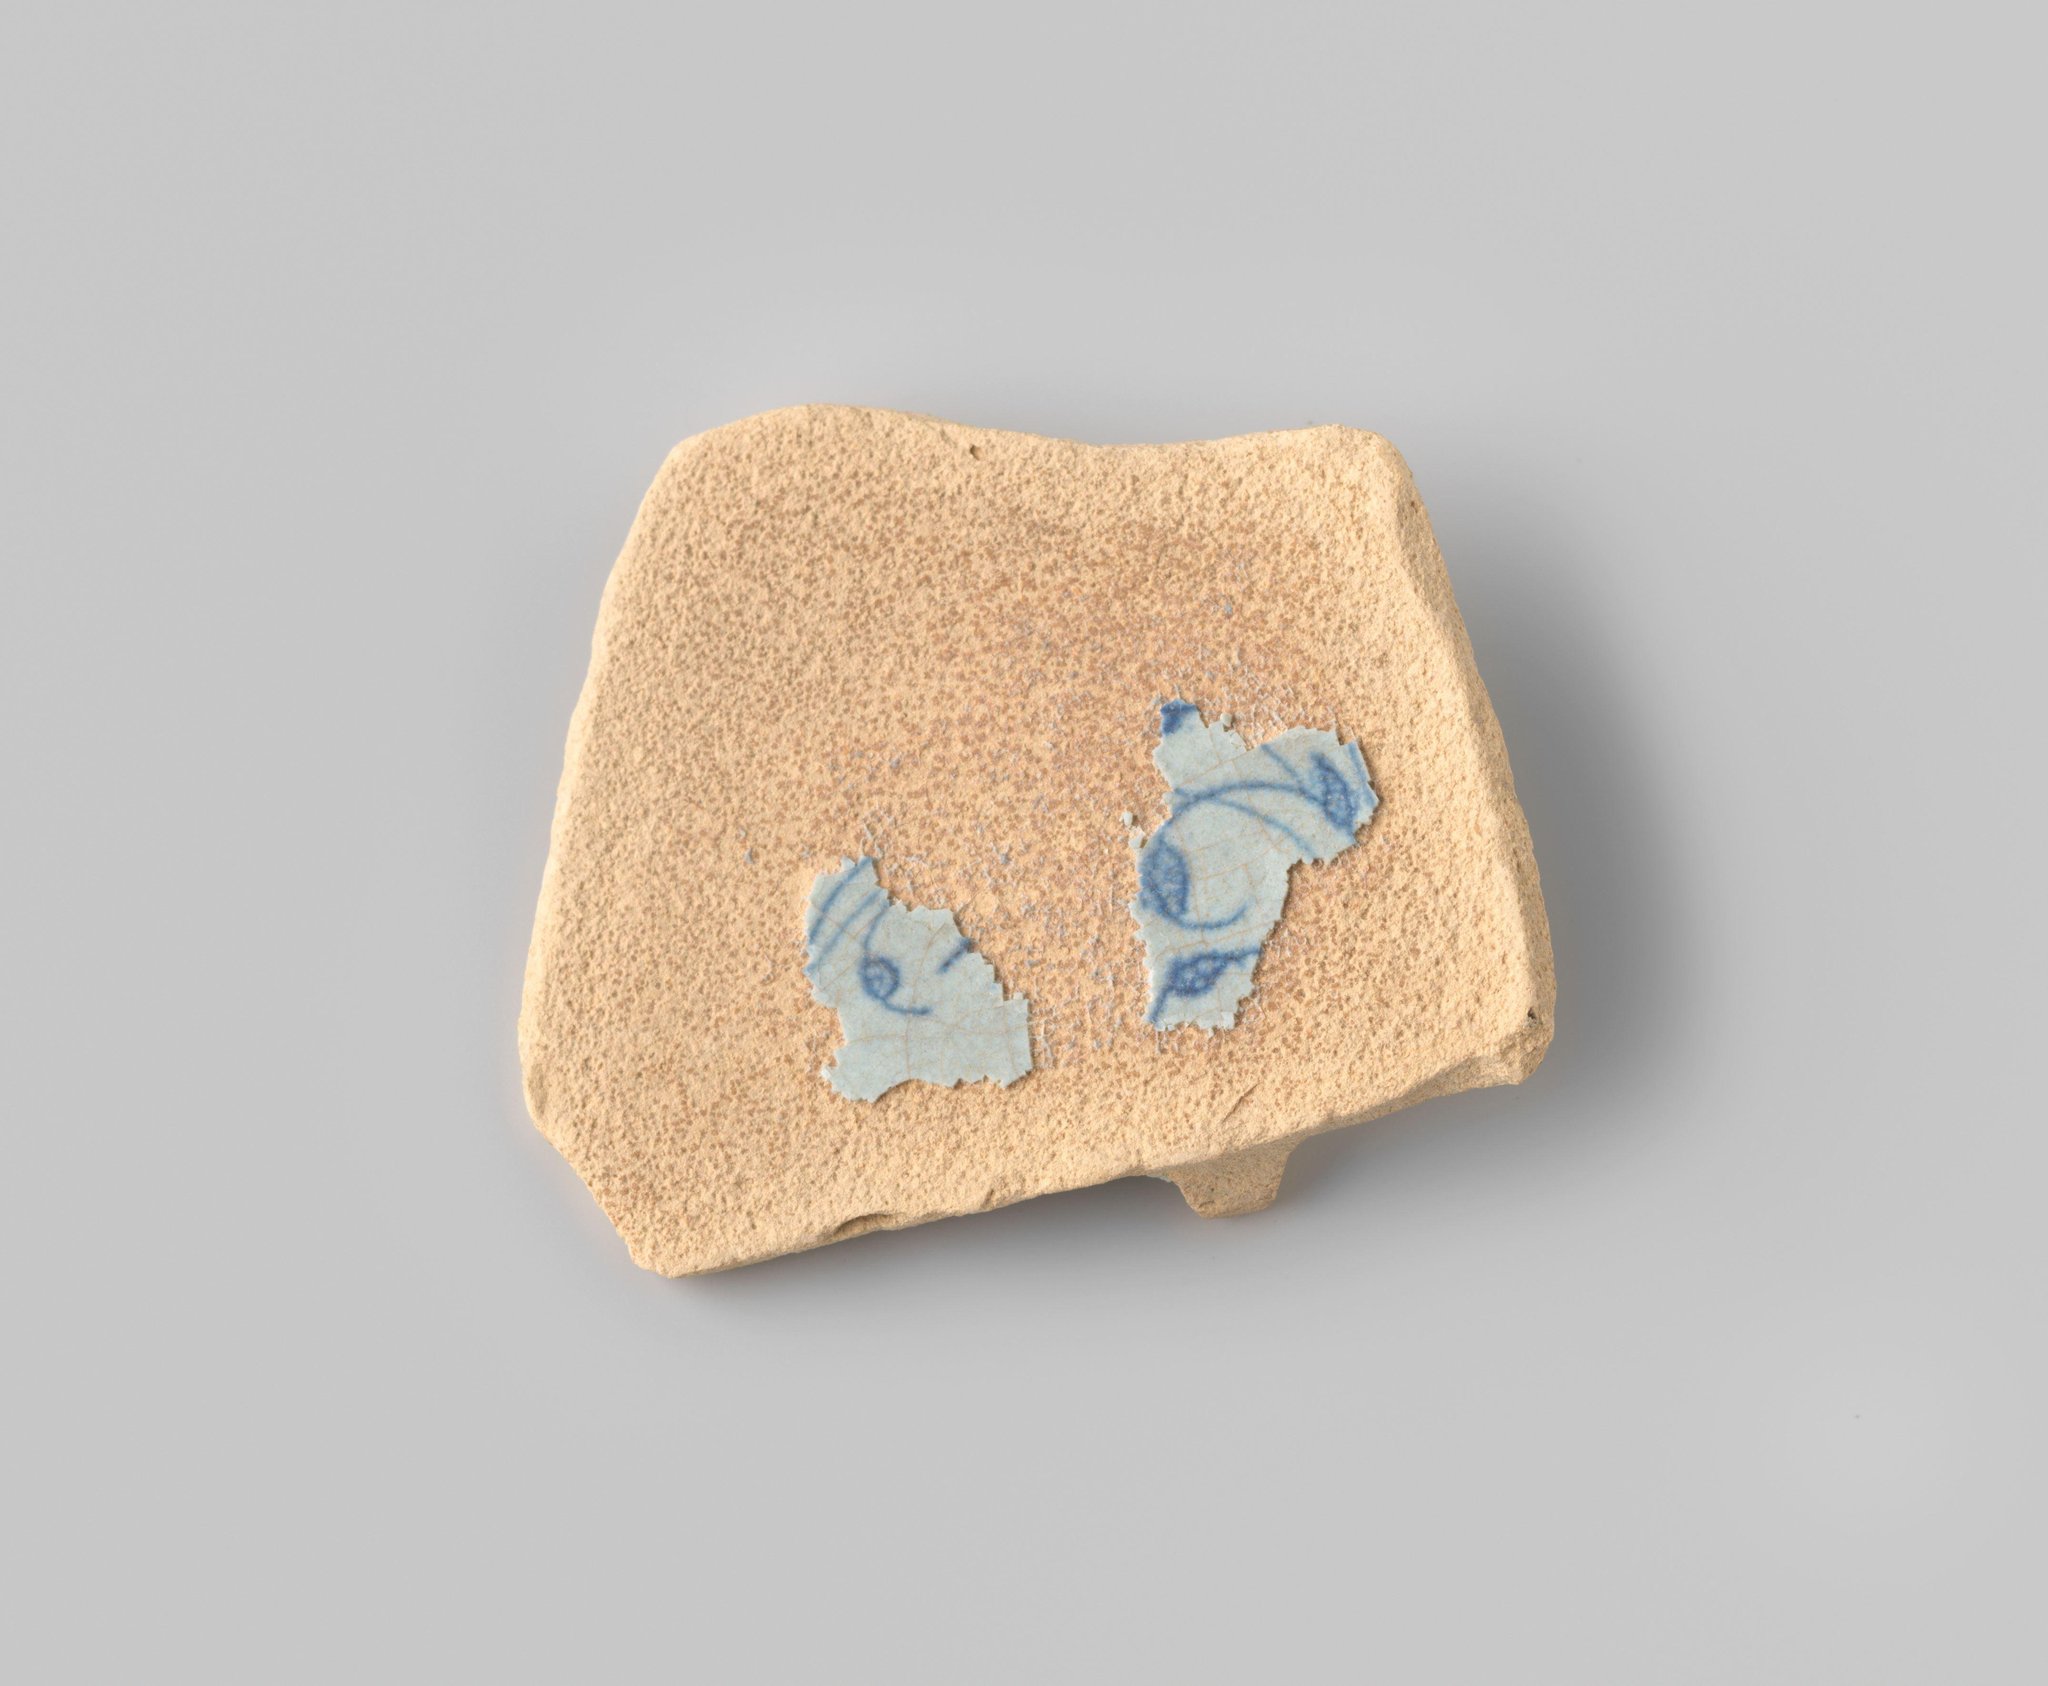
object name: sherd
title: Fragment (voet) met gele scherf, aan de onder- en bovenzijde nog enkele stukjes grijs-blauw glazuur, met aan de bovenkant enkele fijne ranken, in een donkerder blauw geschilderd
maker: Anonymous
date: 1545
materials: earthenware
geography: italy